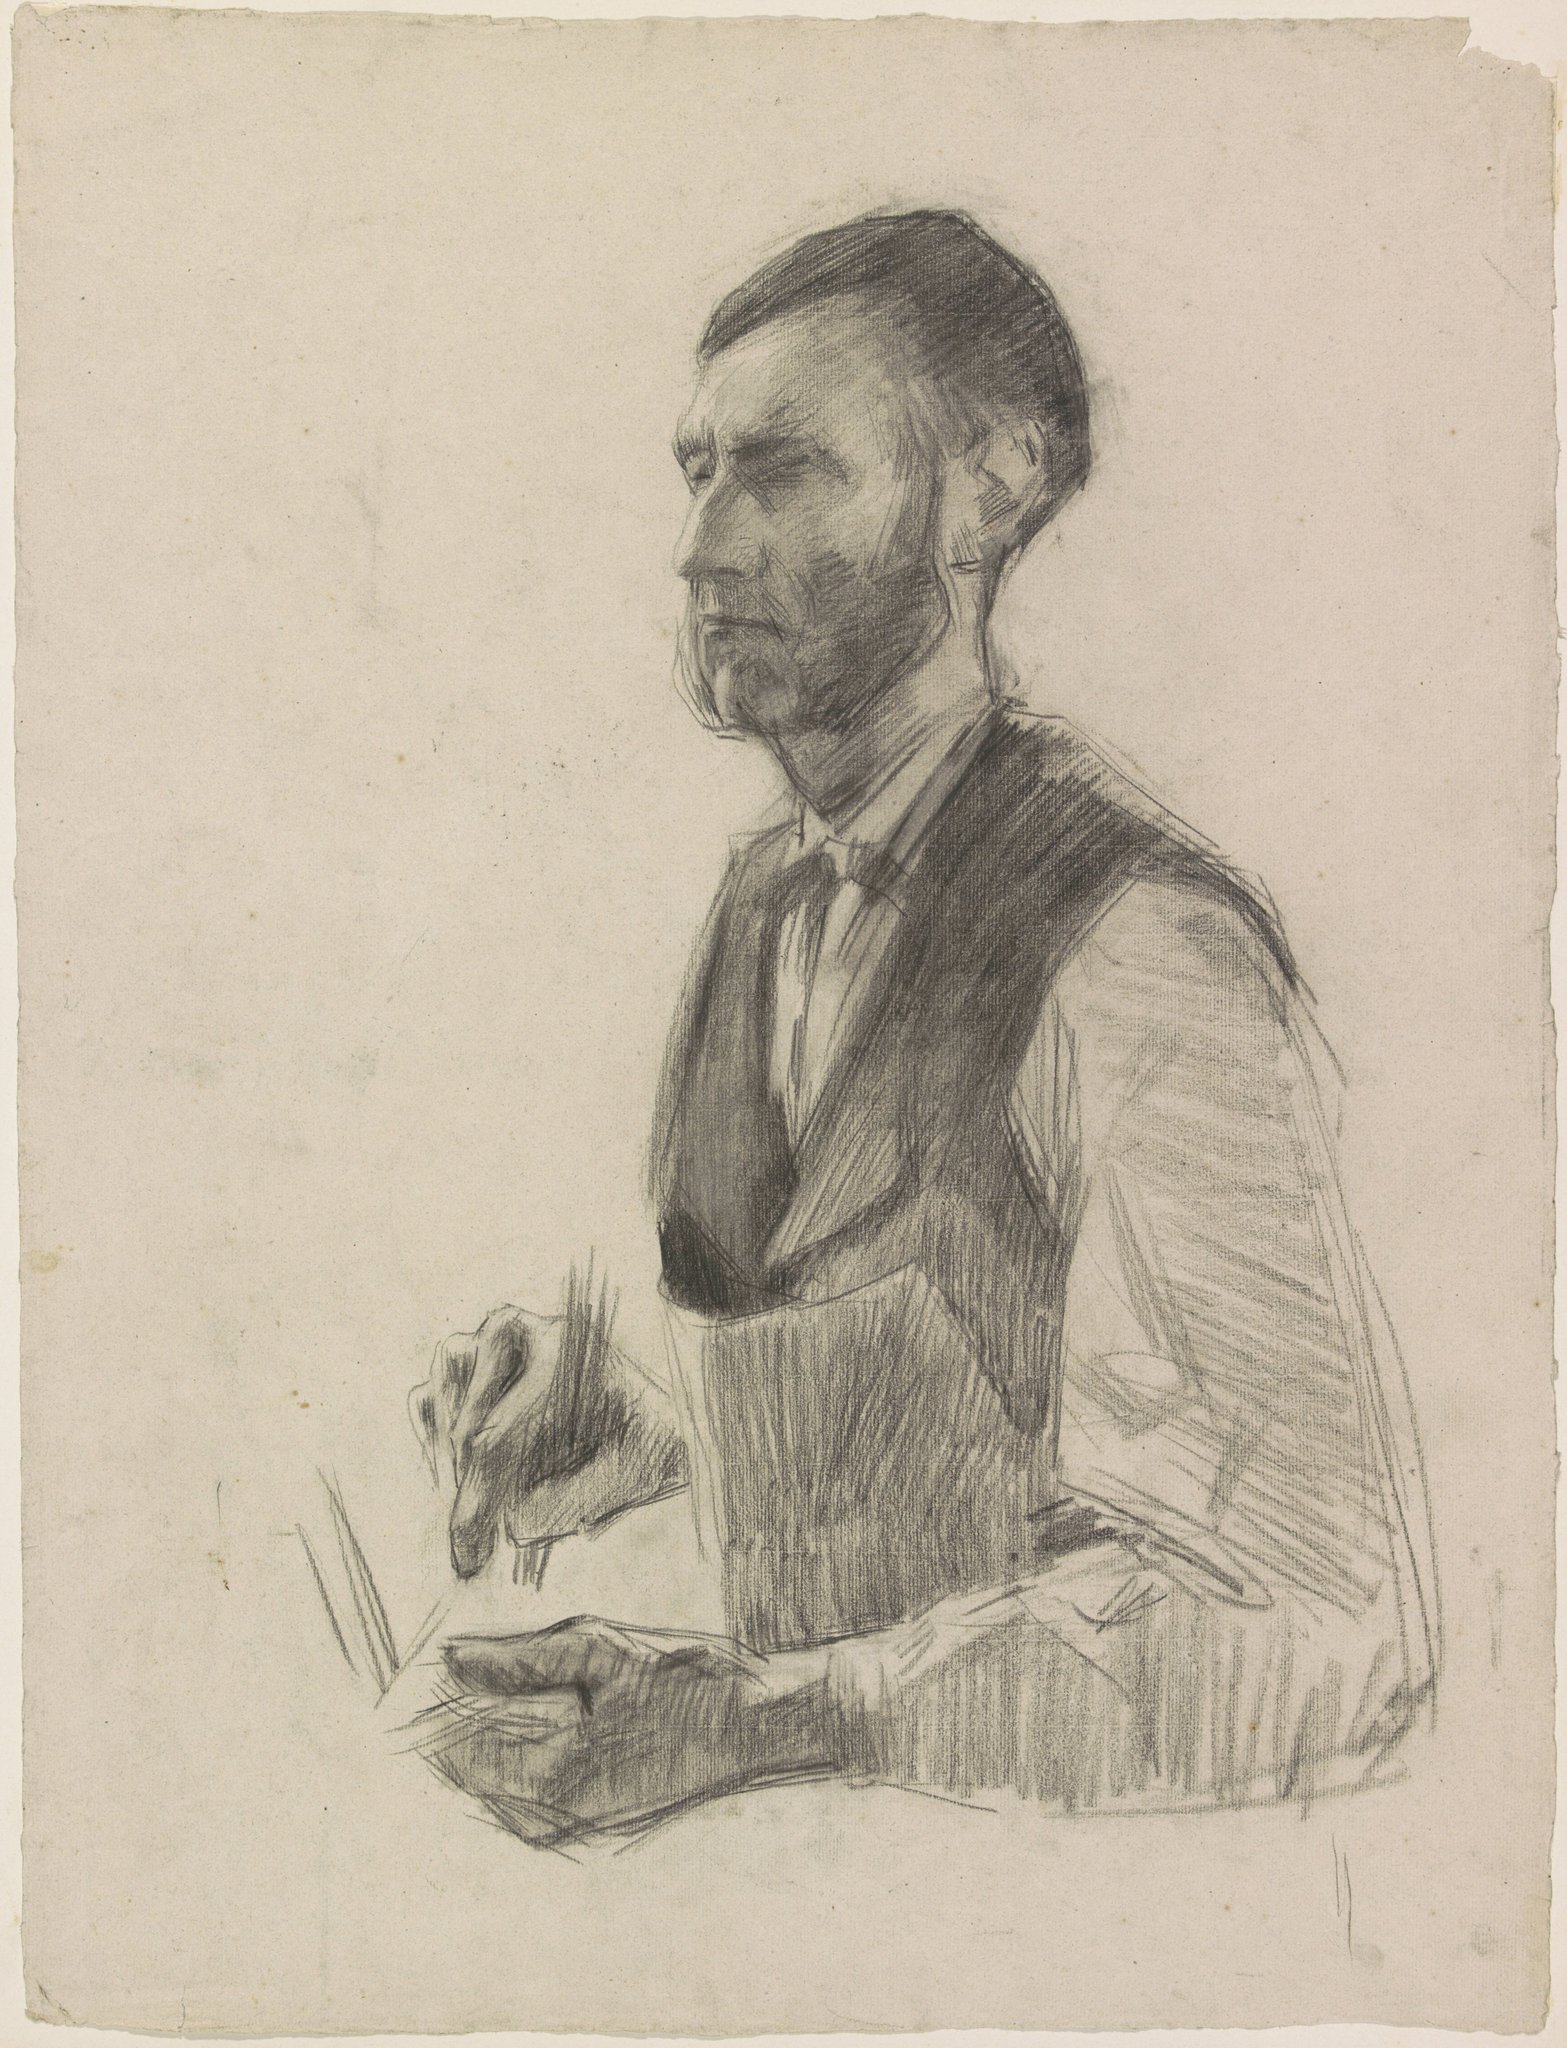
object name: drawing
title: Blinde borstelmaker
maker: anthon gerhard alexander van rappard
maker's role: draughtsman, print maker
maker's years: 1858-1892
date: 1868-1892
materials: charcoal, paper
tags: (household) utensils and implements (with name), handicrafts ~ other animal material, blind, blindness